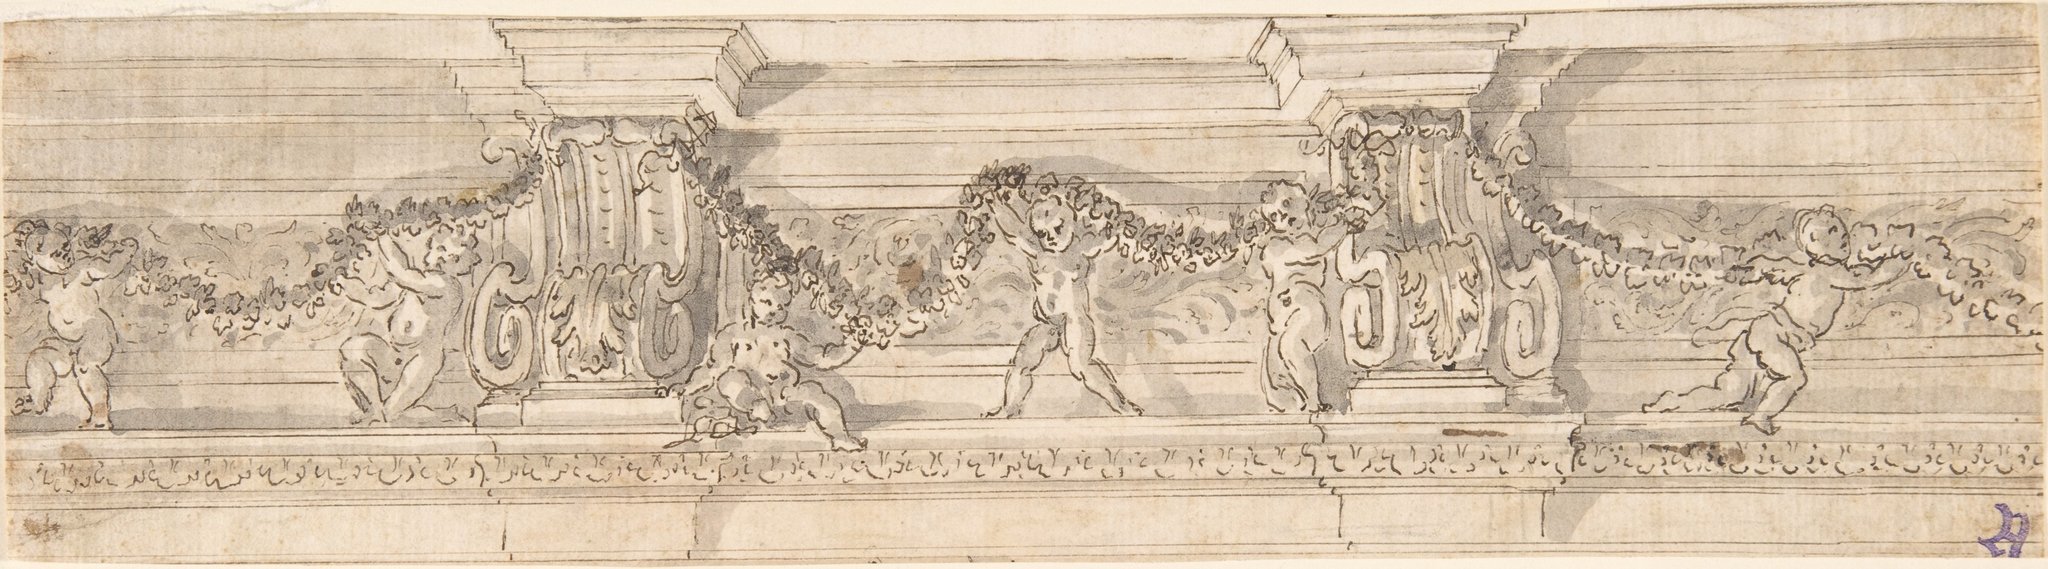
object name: drawing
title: Frieze with Consoles, Putti, and Garlands (recto); Fragment of Architectural design (verso)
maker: anonymous, italian, 17th century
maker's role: artist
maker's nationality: italian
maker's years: 1600-1700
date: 1601-1700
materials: graphite, ink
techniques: brush, pen, wash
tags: garlands,putti